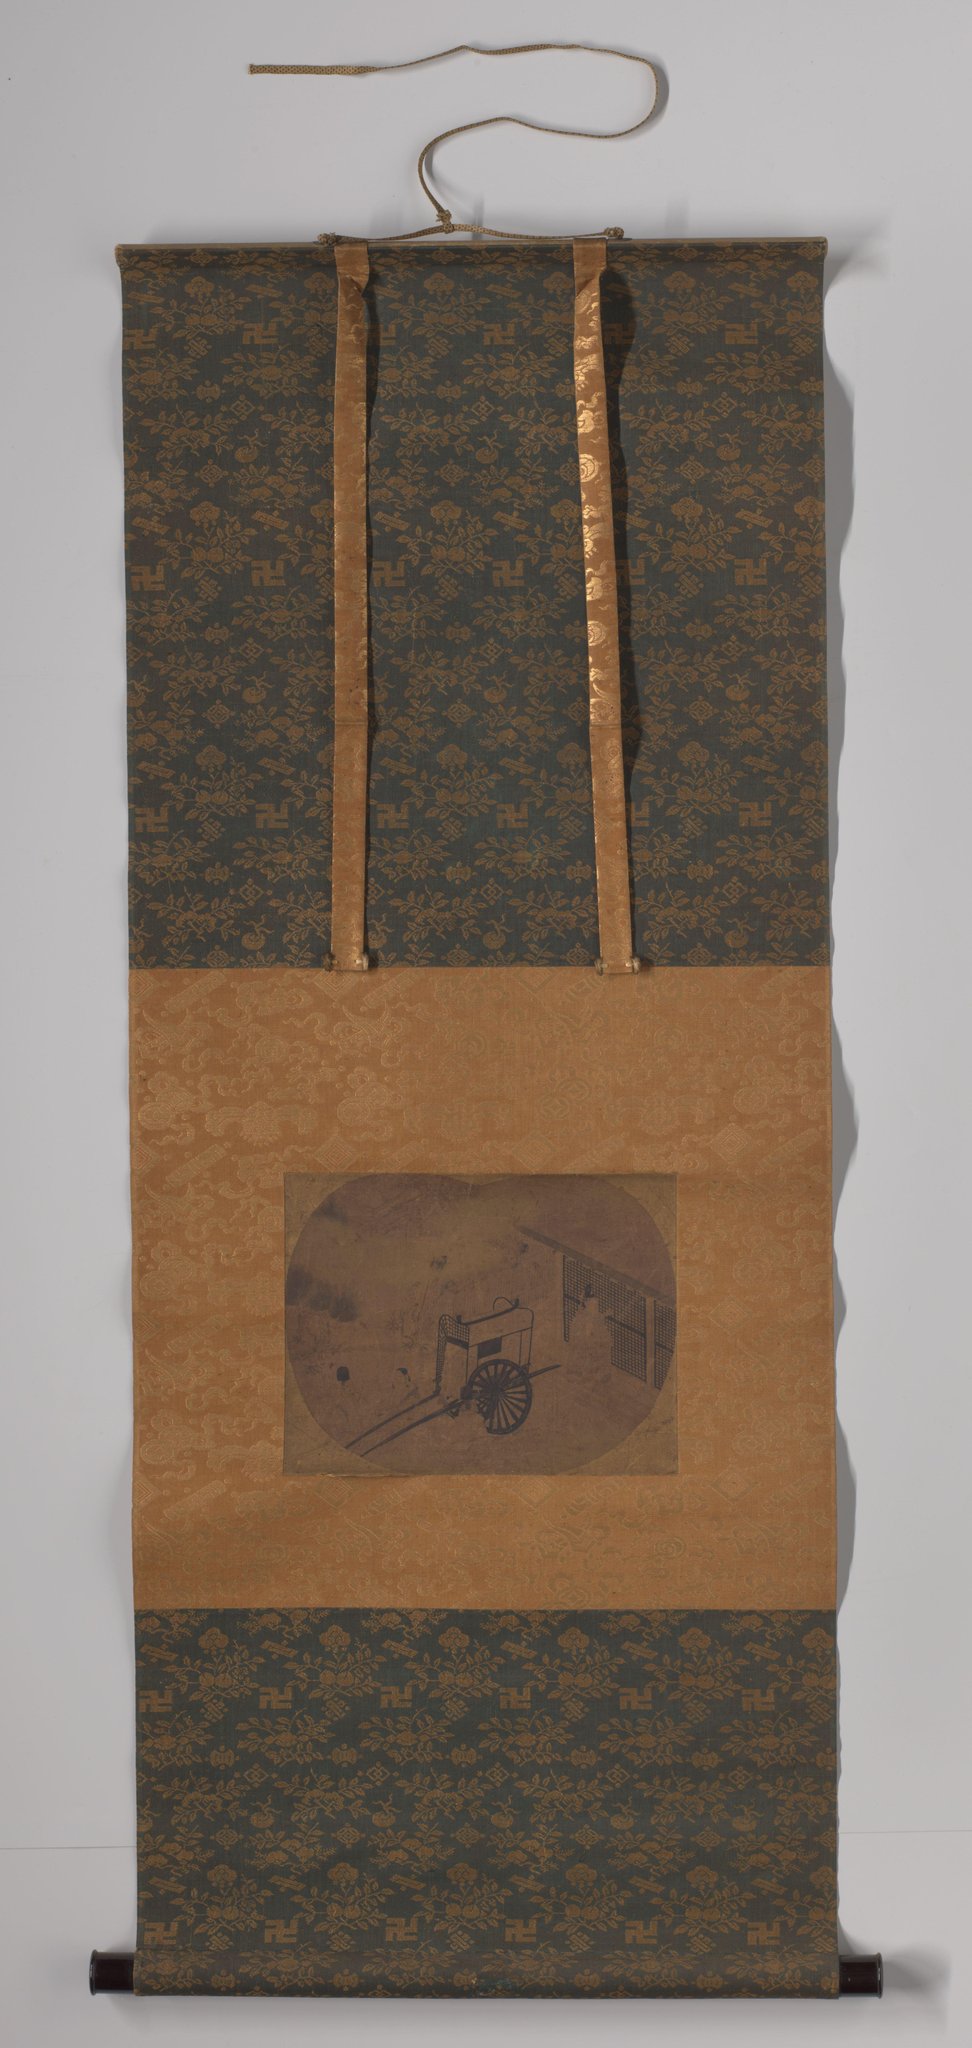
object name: hanging scroll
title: Rolschildering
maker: Anonymous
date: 1600-1800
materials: ink, paper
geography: japan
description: Een wagentje met figuren, een episode uit het leven van Genji. Het papier is in suhama-vorm. In houten doos.